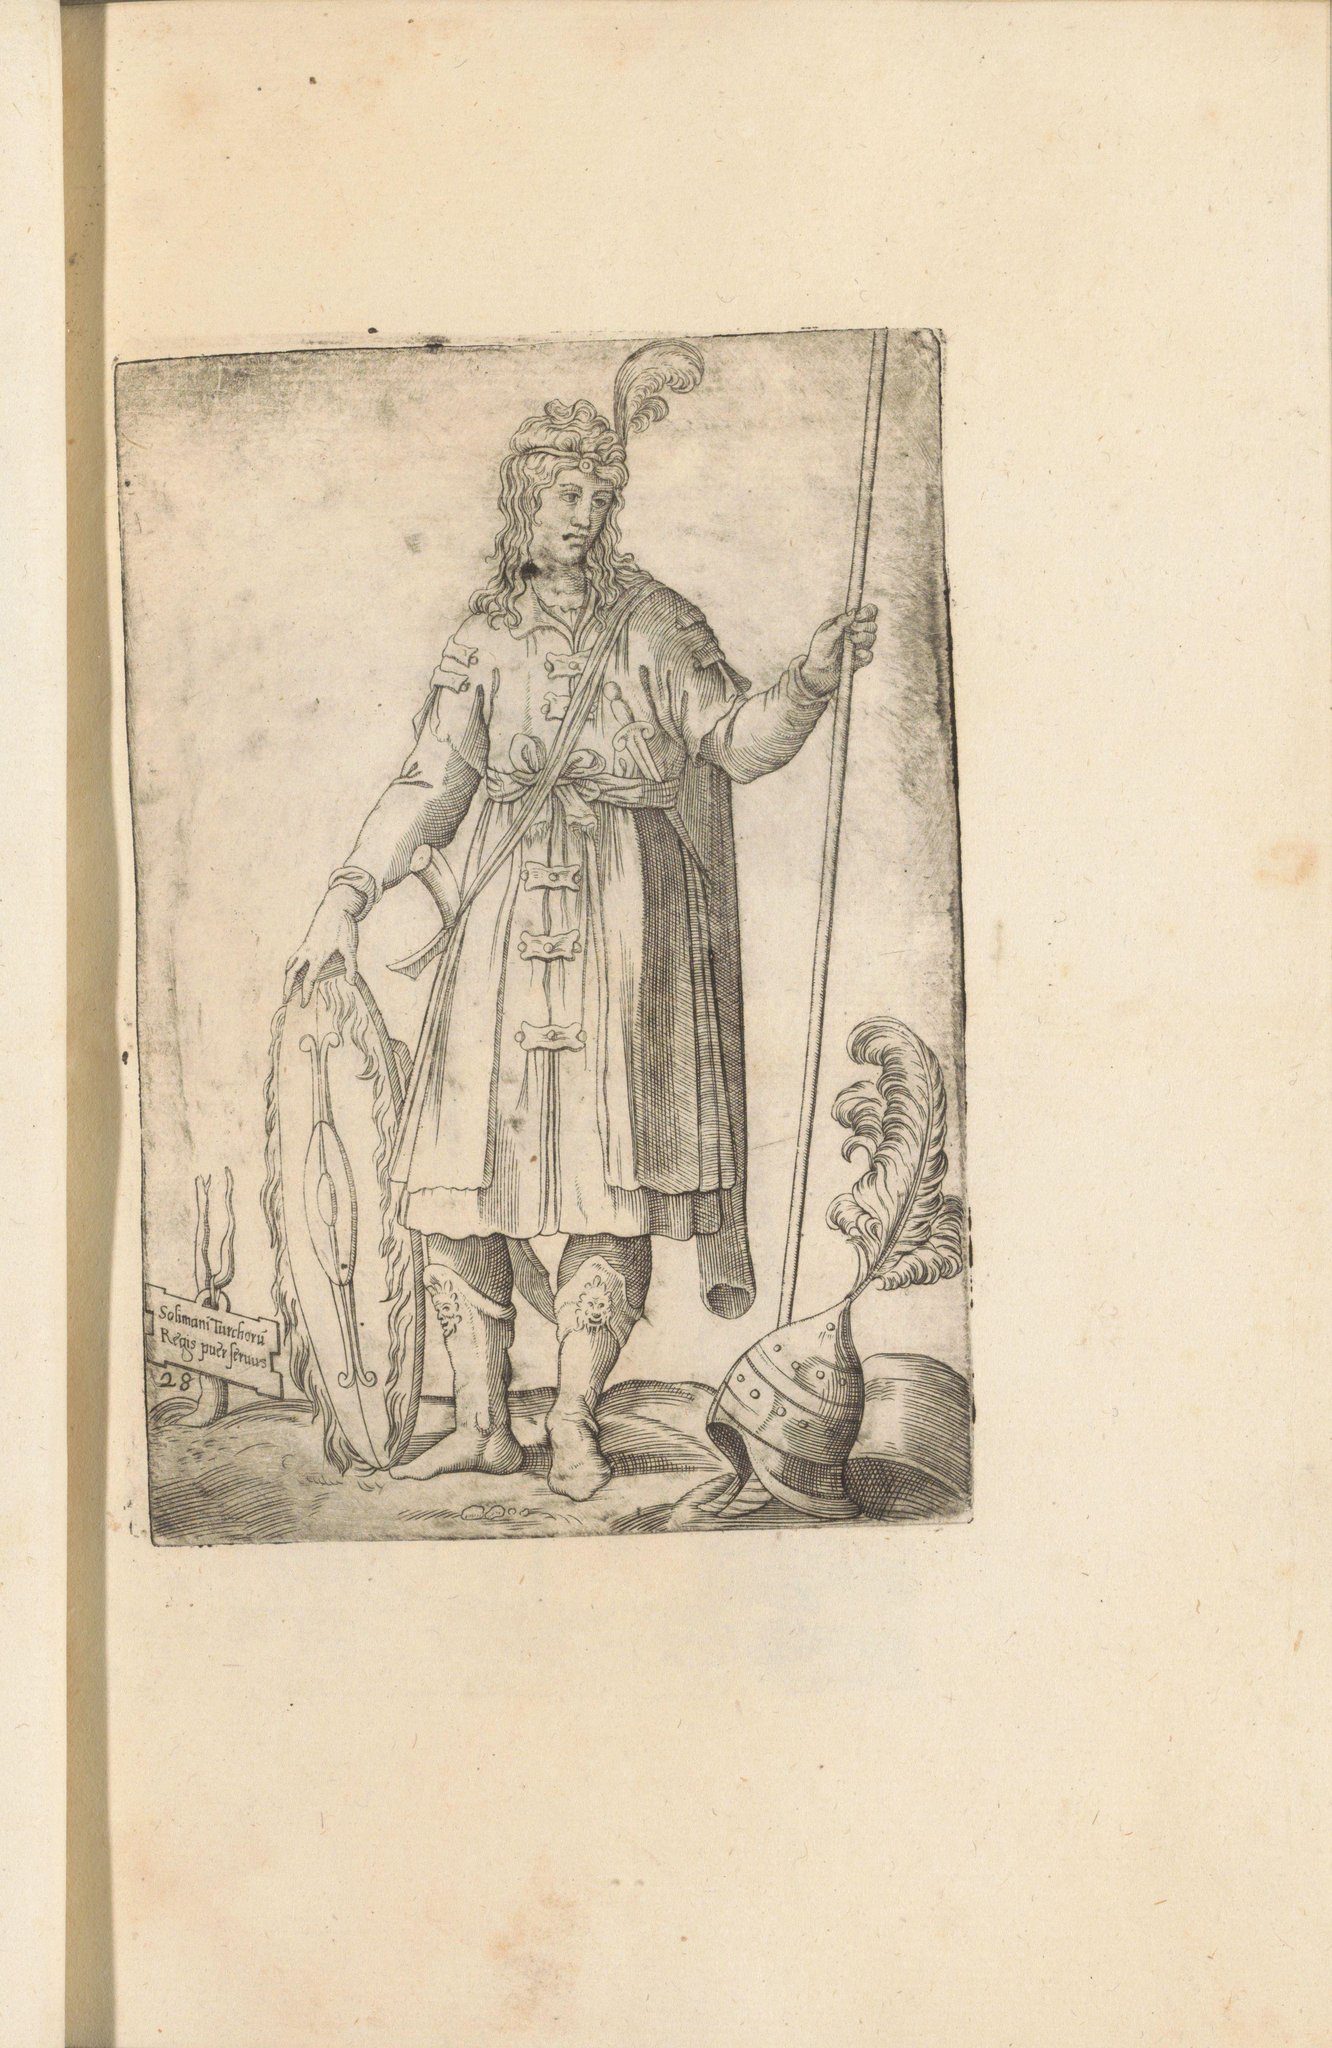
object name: costume print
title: Omnium fere gentium nostrae aetatis habitus, nunquam ante hac aediti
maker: ferando bertelli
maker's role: print maker, publisher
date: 1569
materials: paper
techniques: engraving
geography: venice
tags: fashion plates, the soldier; the soldier's life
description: Turks soldaat onder Sultan Süleyman de Grote. Staand met wapenschild en lans, helm ligt op de grond. Onderdeel van het kostuumboek getiteld 'Omnium fere gentium nostrae aetatis habitus, nunquam ante hac aediti', Venetië 1569. Heruitgave uit 1569 van de eerste editie uit 1563.